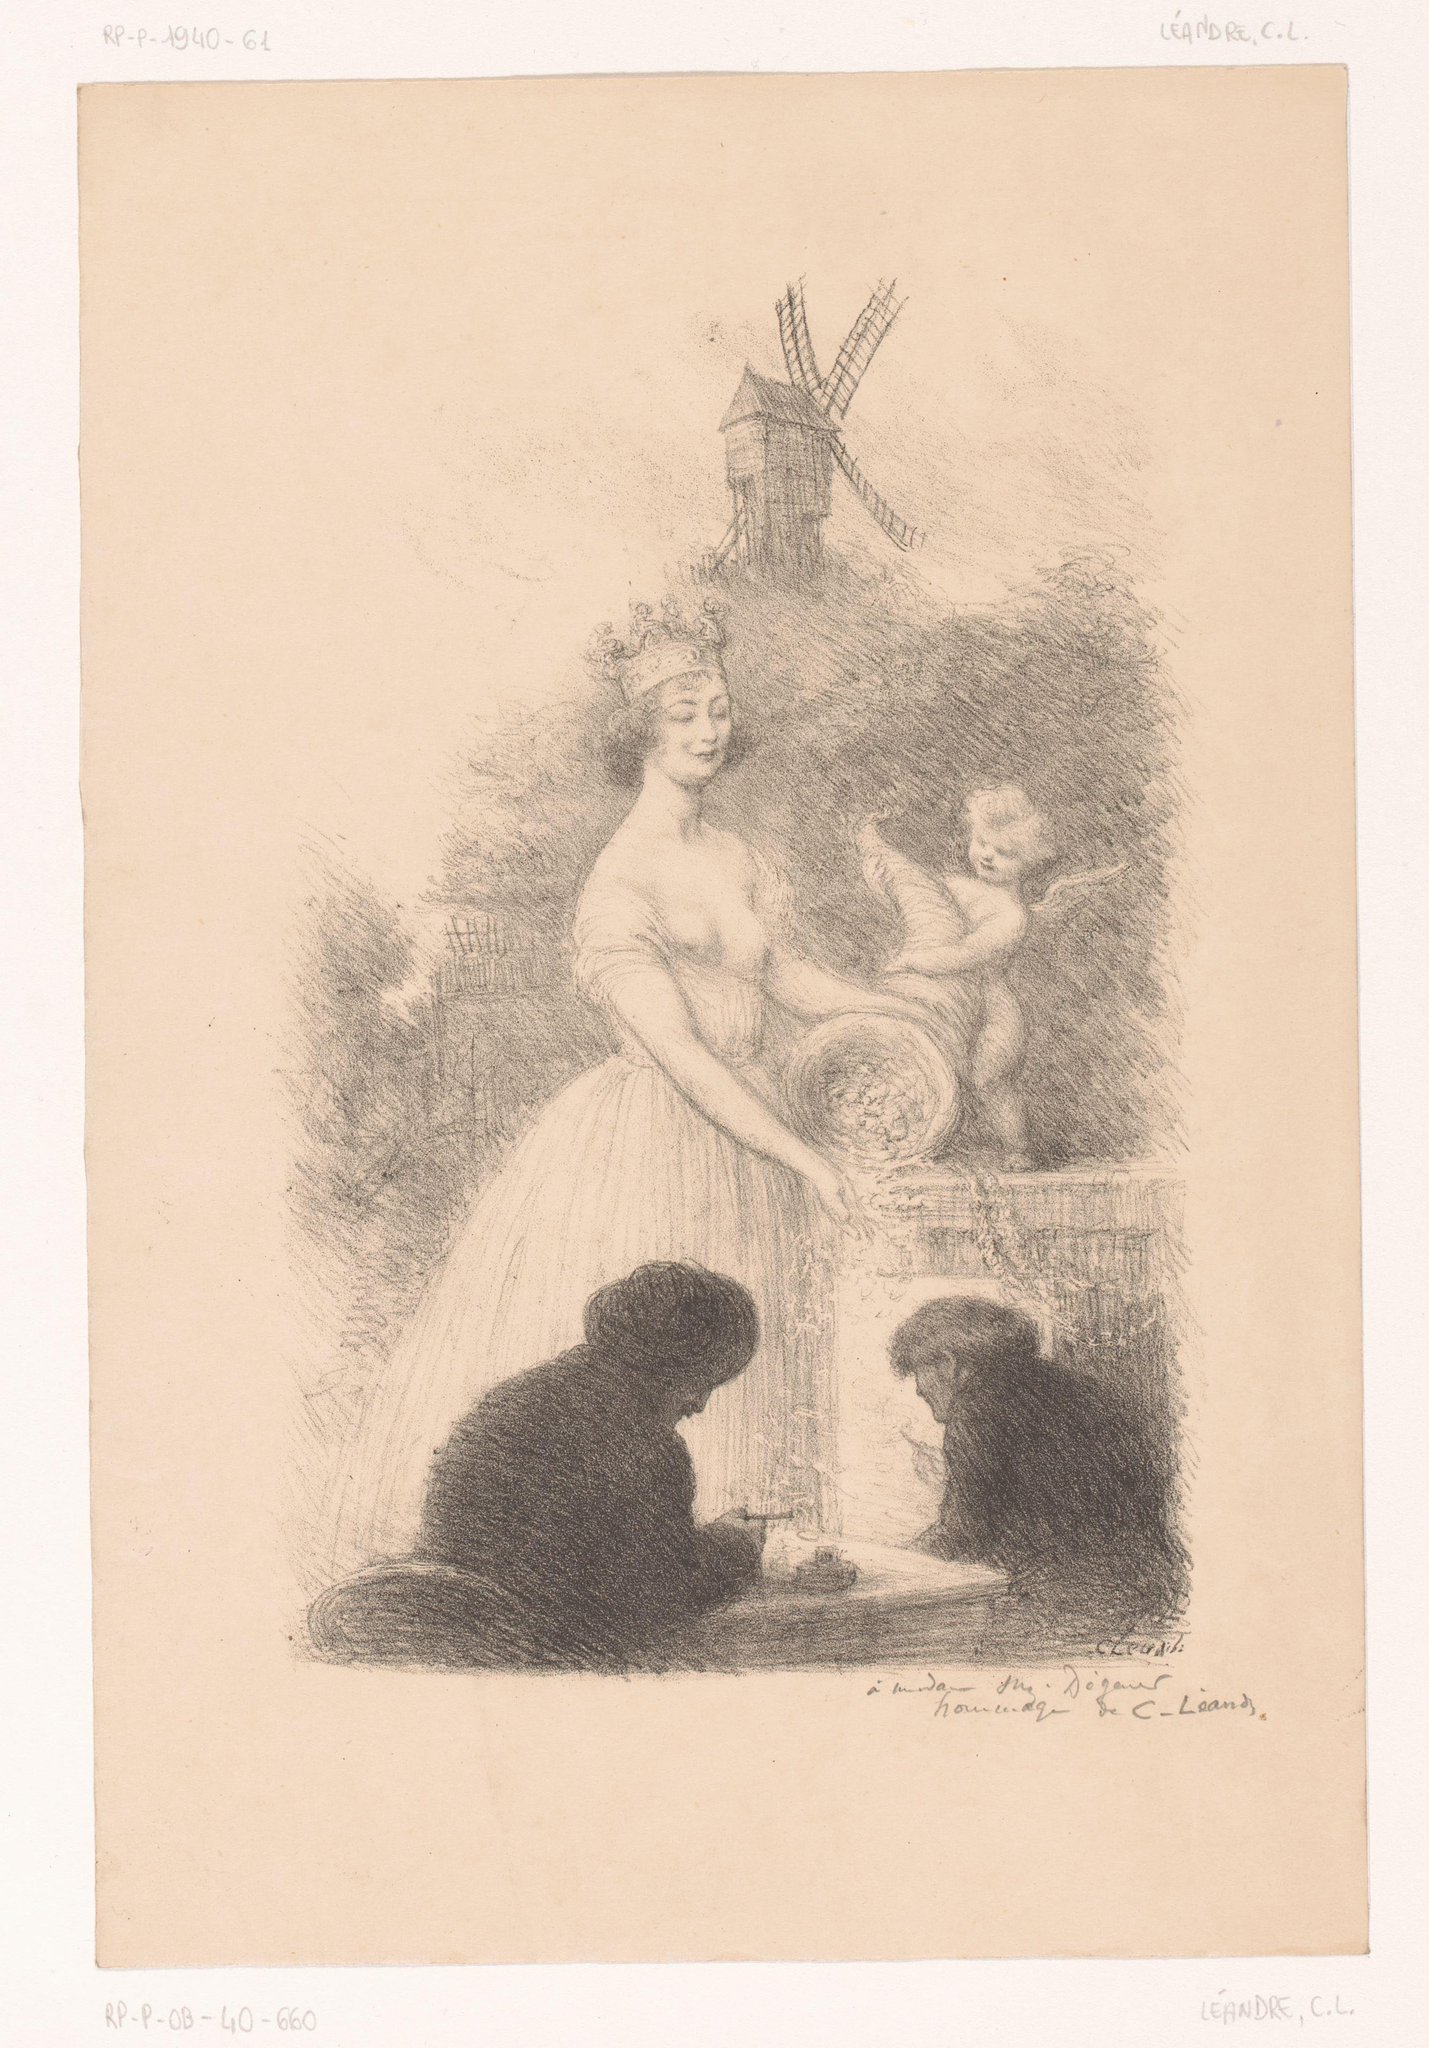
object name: print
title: Gekroonde vrouw en putto met hoorn des overvloeds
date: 1891-1934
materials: paper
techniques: lithography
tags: 'cornucopia', horn of plenty, crown (symbol of sovereignty) - bb - female ruler, windmill, cupids: 'amores', 'amoretti', 'putti'